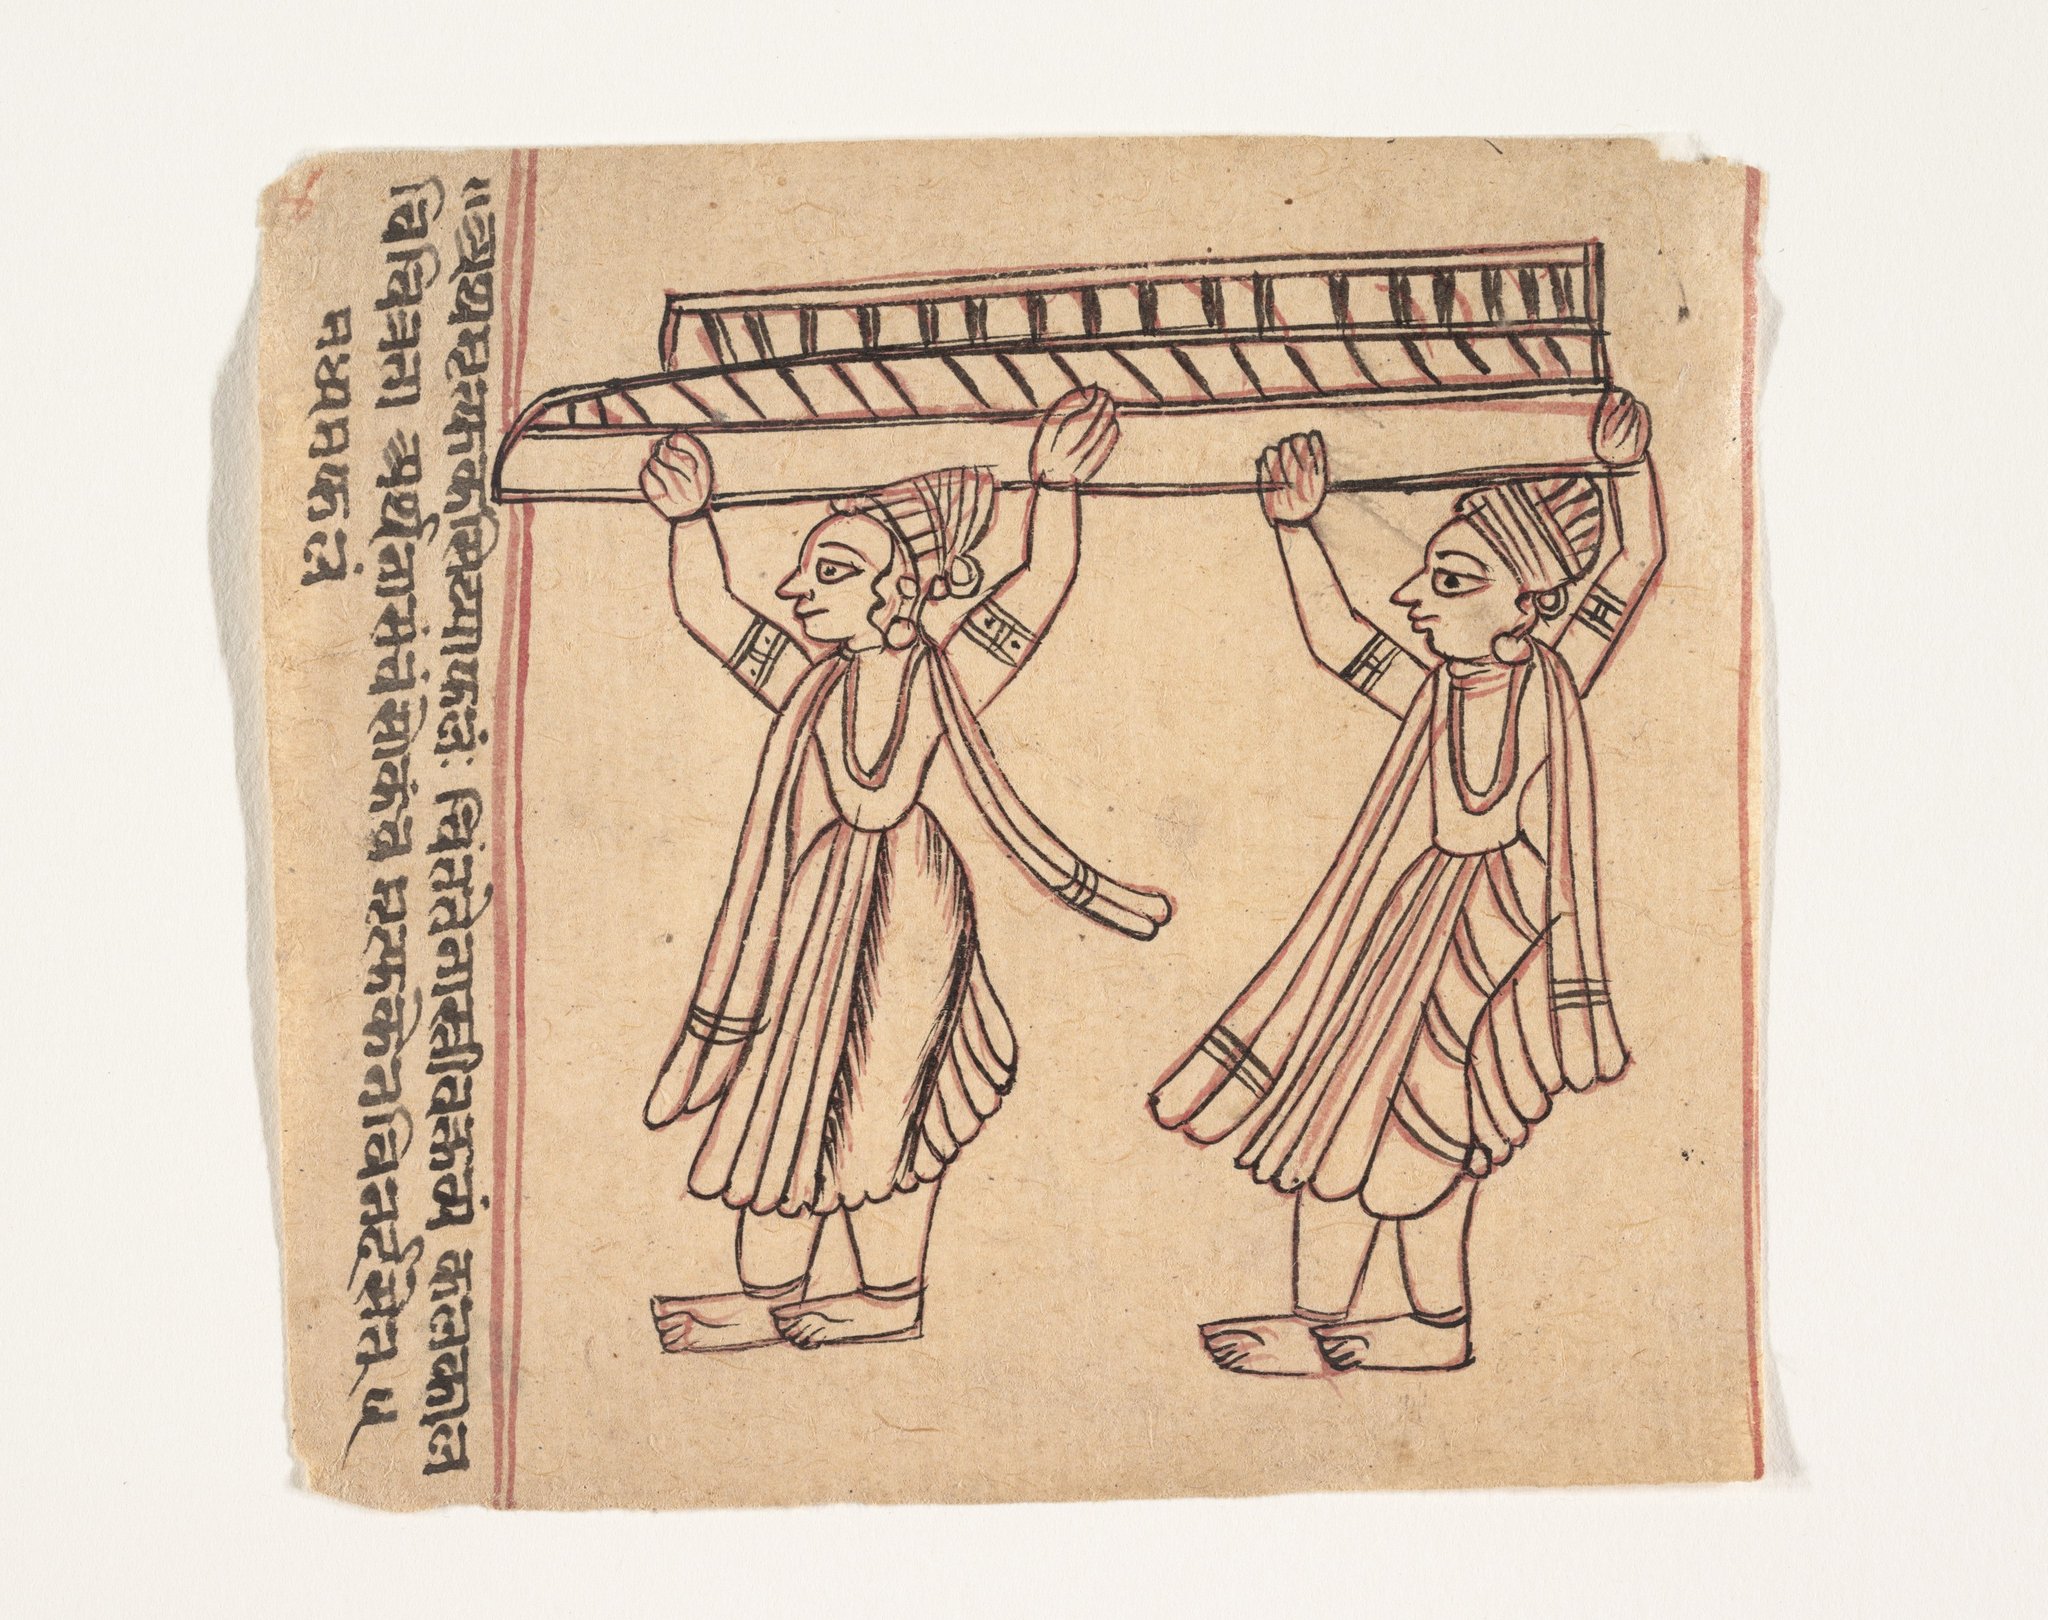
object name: folio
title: Page from a Book of Omens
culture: indian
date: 1800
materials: ink, paper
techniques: wash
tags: men,boats